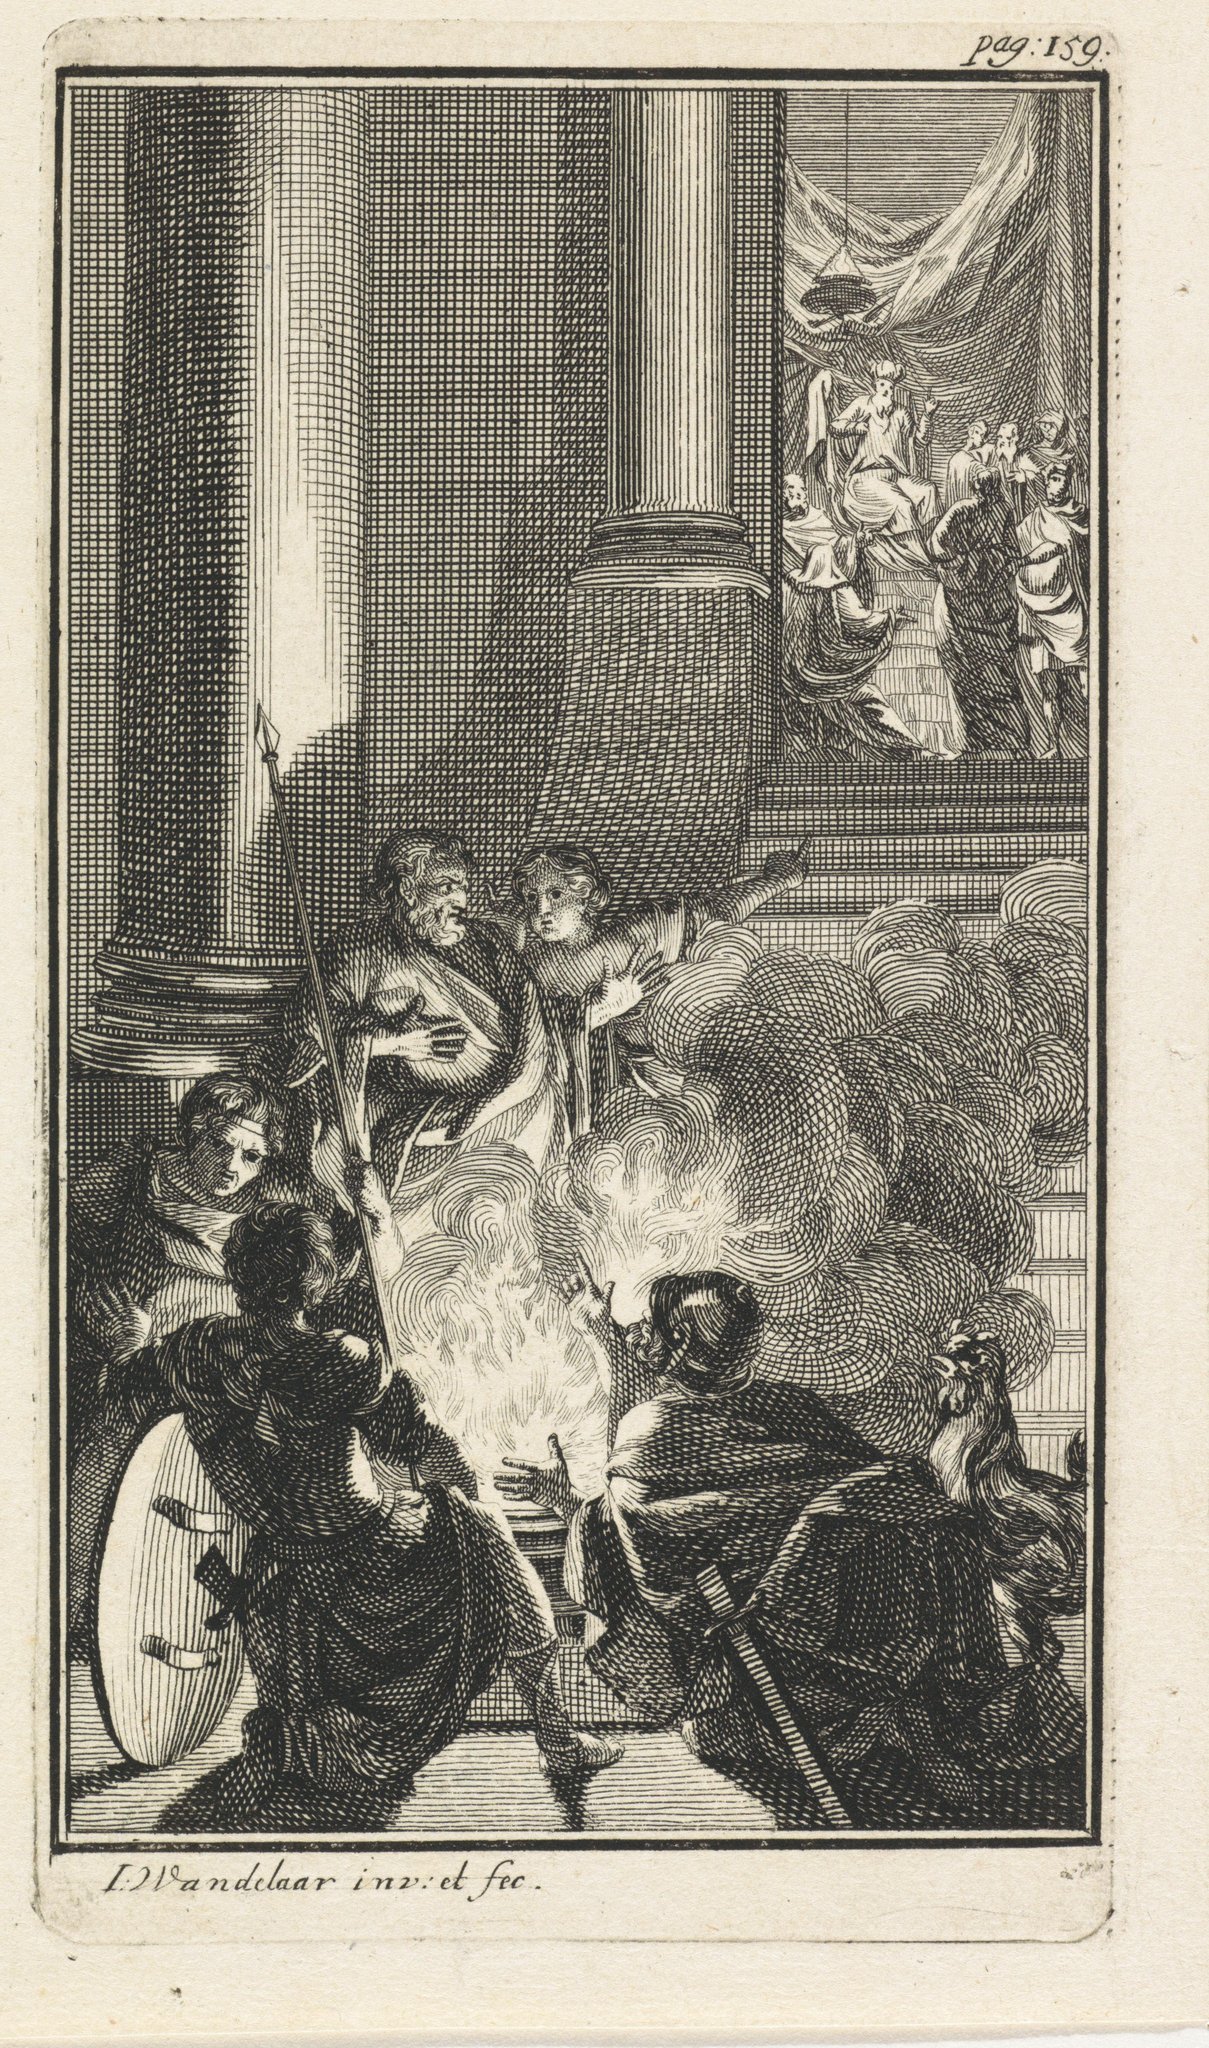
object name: book illustration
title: Petrus verloochent Christus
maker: jan wandelaar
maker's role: draughtsman, print maker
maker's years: 1690-1759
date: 1725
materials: paper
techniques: engraving, etching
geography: northern netherlands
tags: peter denies christ, usually before a girl-servant and some soldiers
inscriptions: collector's mark: Lugt 240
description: De prent is als boekillustratie gebruikt in: Hoek, Kornelis van. De vernederde en verhoogde Kristus, behelzende 's Heylands geboorte, leven, lyden, sterven, en begravenis, opstandinge, hemelvaart, zittinge aan Gods regterhand, en komst ten oordeel. Amsterdam: Jacob ter Beek, 1725